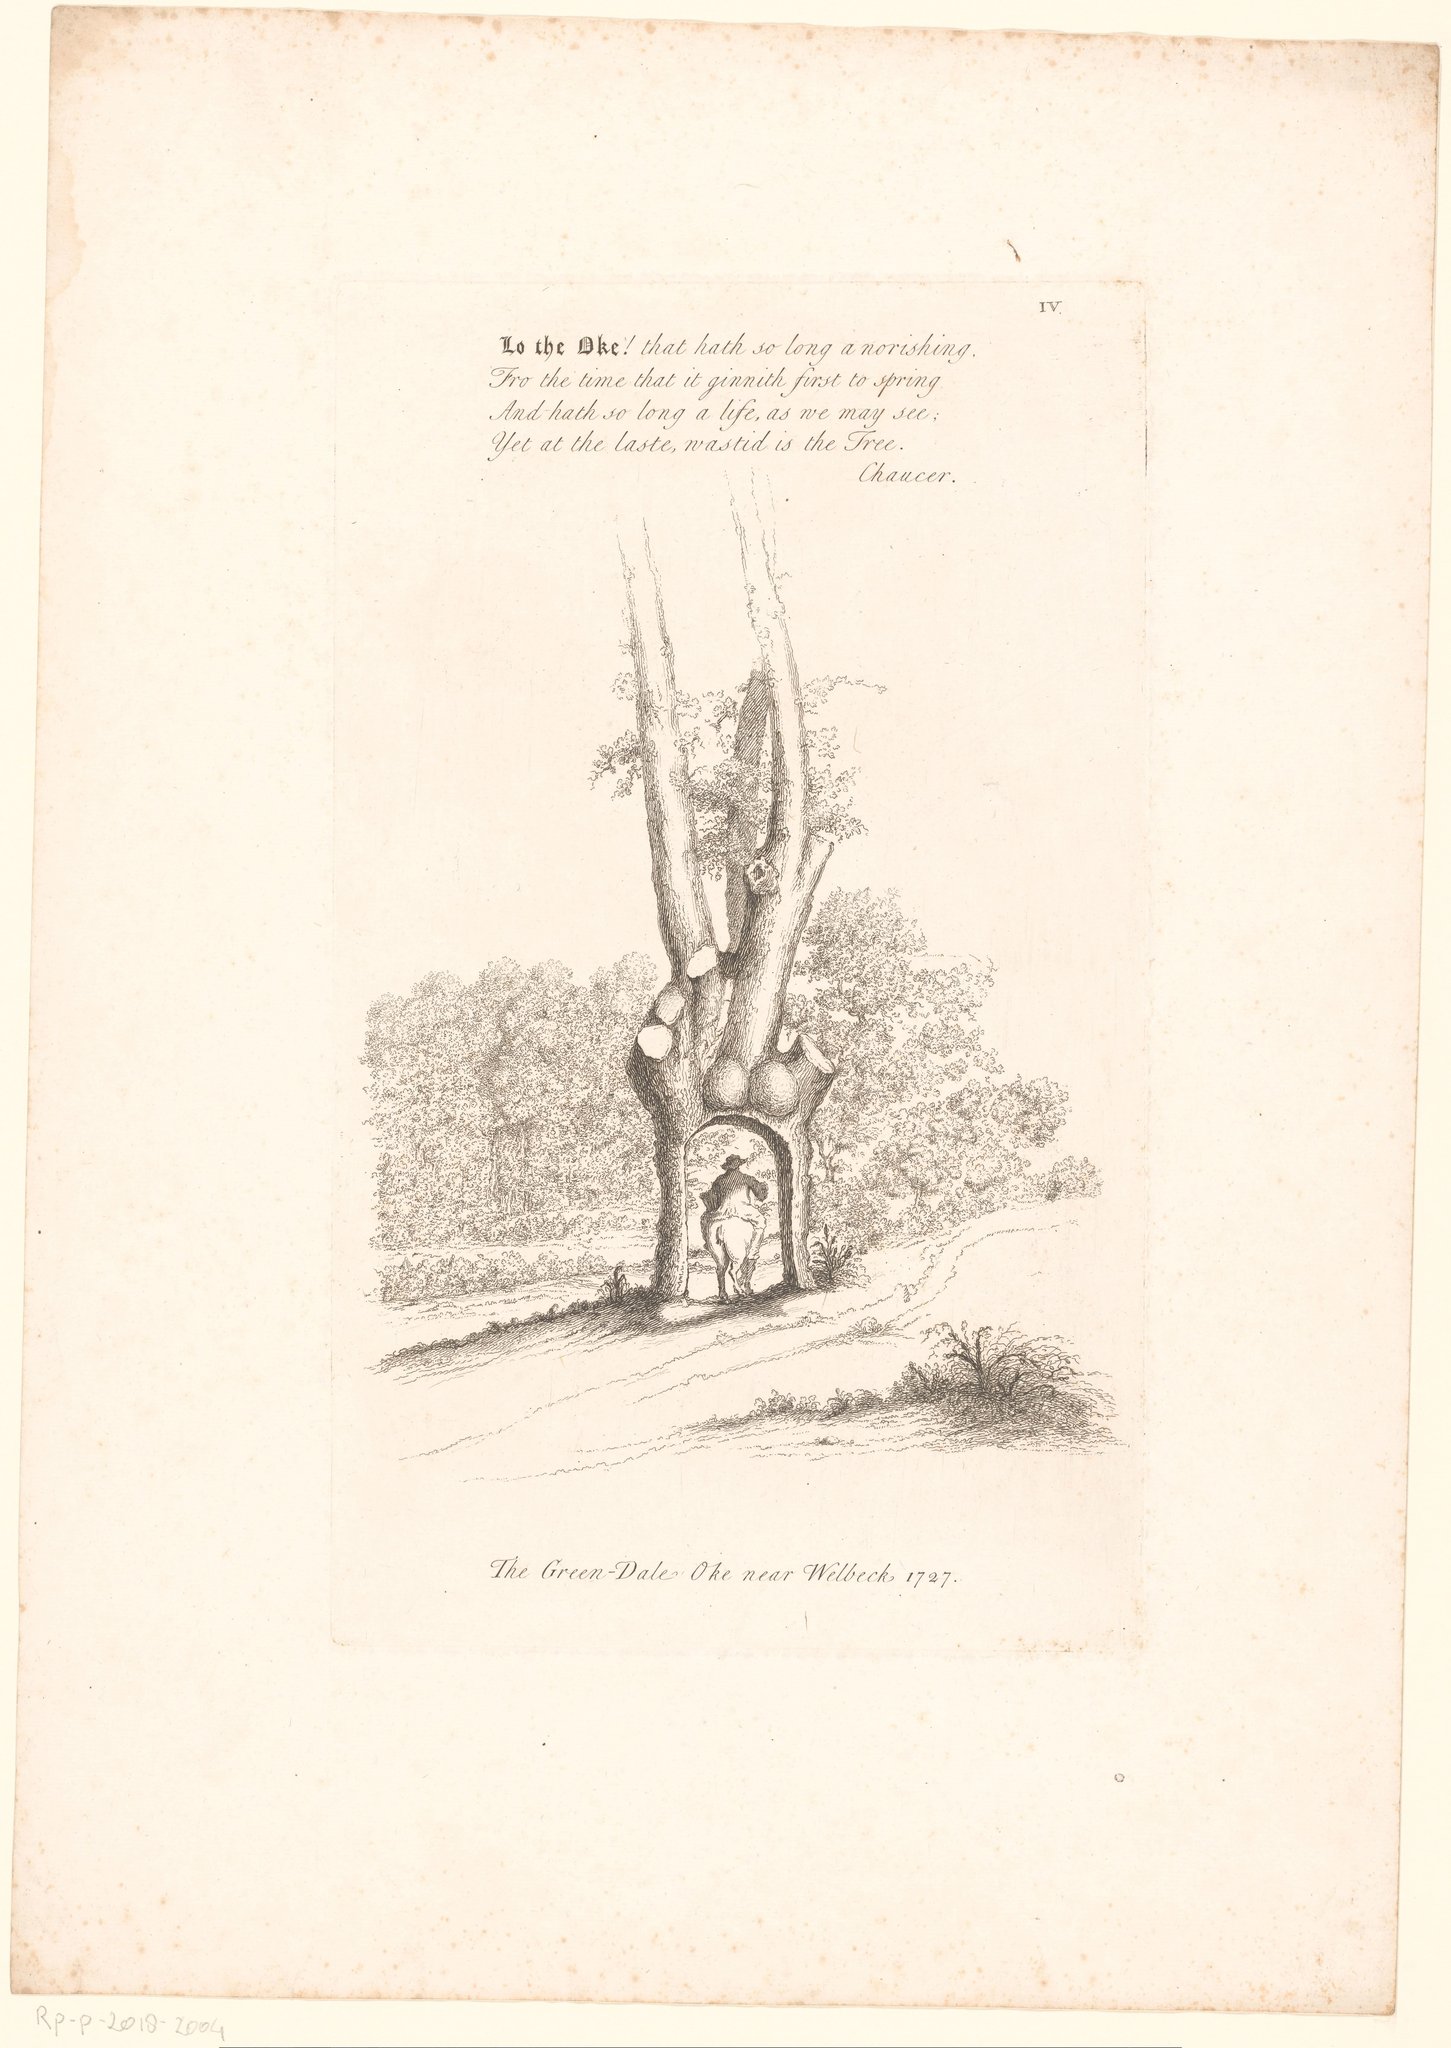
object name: print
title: The Green Dale Oke near Welbeck, 1727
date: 1727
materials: paper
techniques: etching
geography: london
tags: trees: oak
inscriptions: collector's mark: Lugt 2228